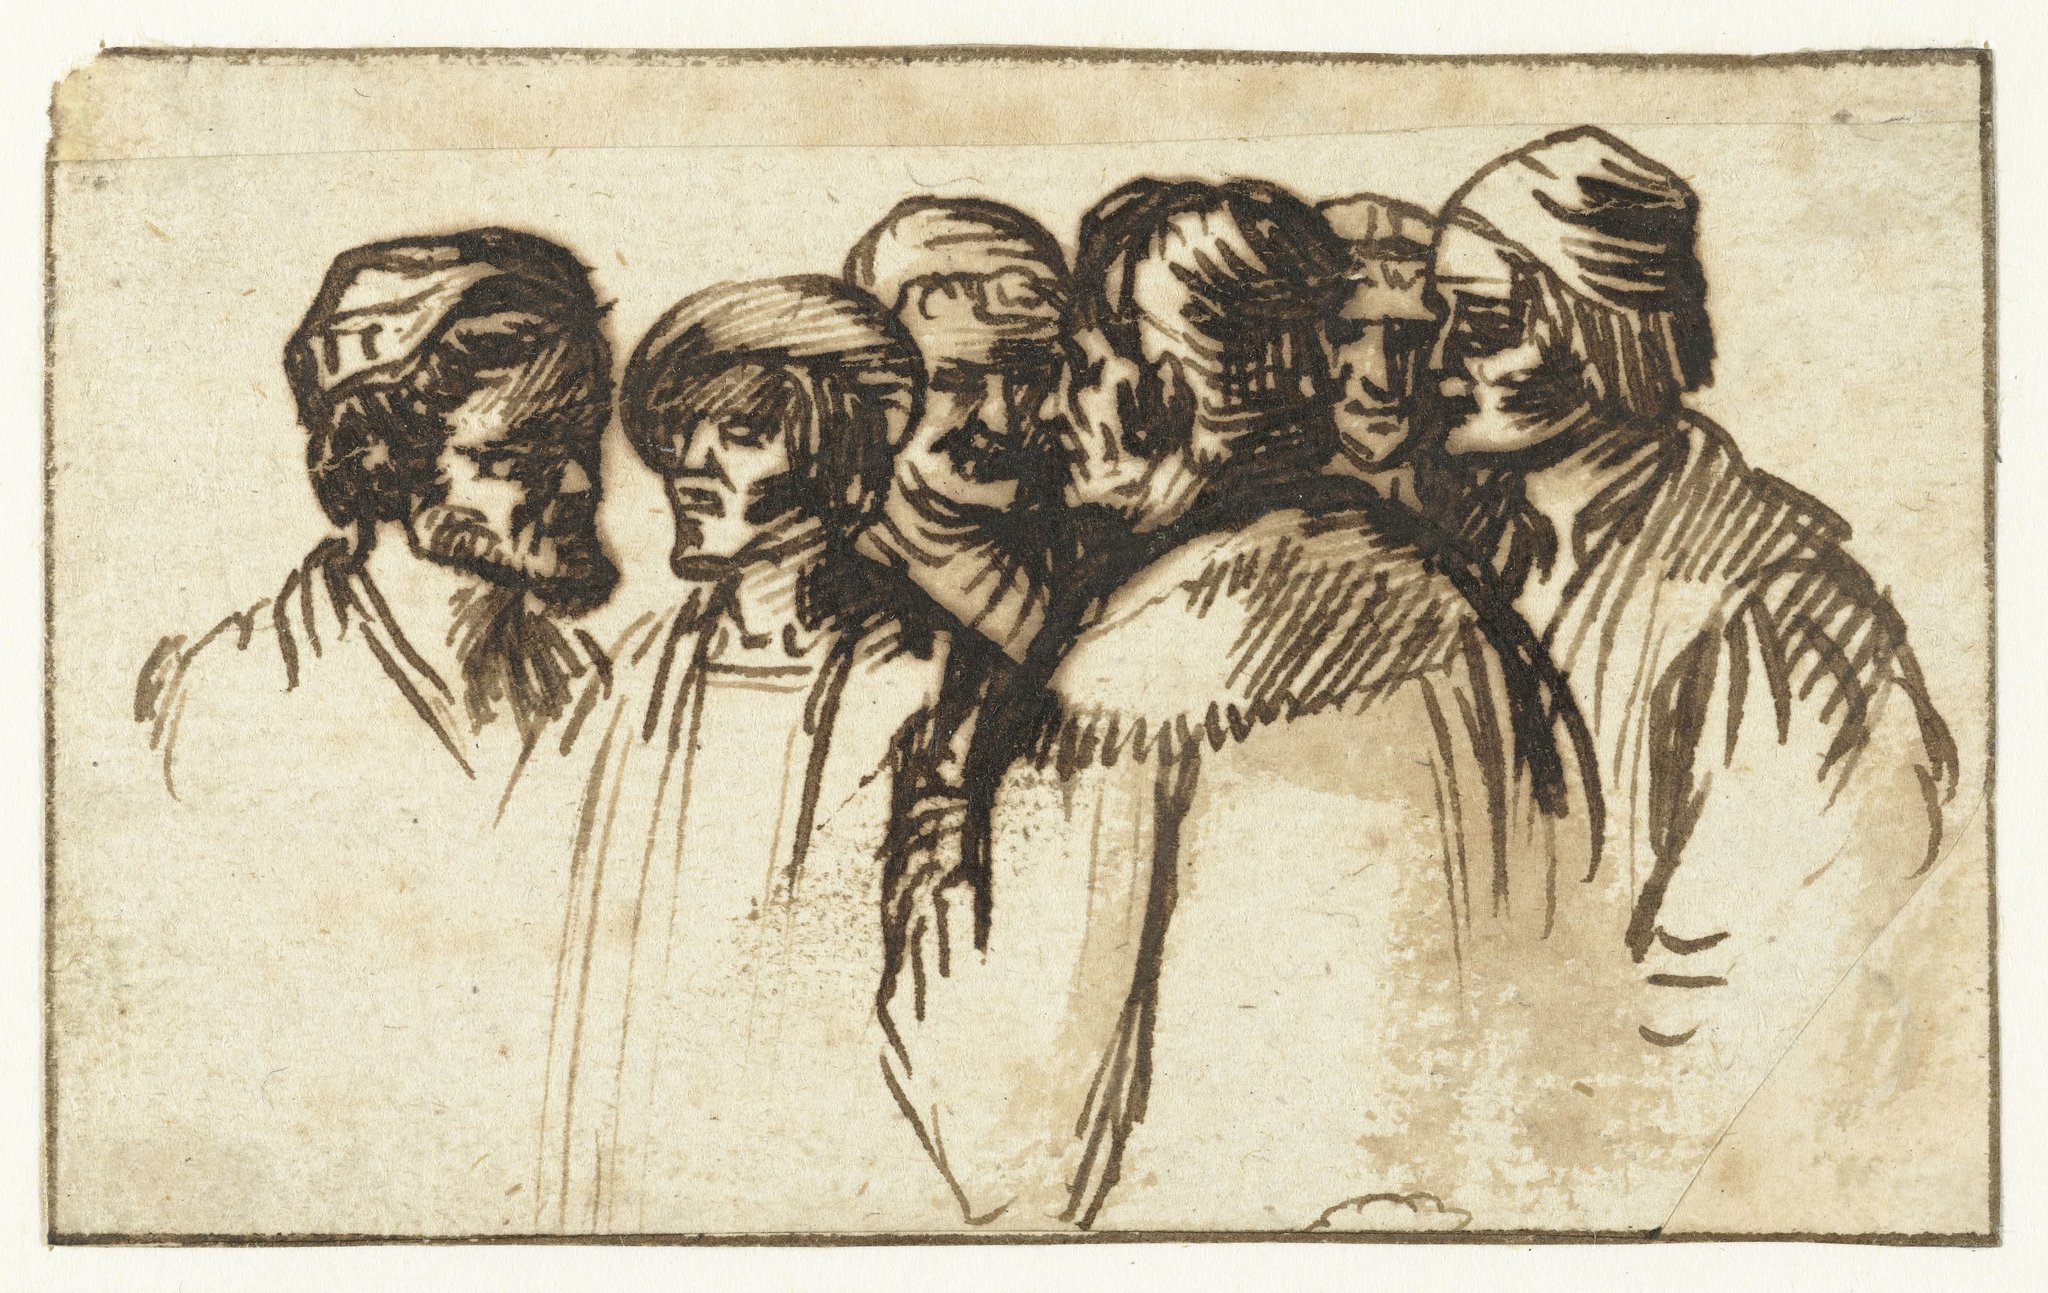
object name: drawing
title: Zes mannen met elkaar in gesprek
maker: hendrick goudt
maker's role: draughtsman, print maker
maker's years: 1581-1648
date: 1580-1650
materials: ink, paper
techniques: brush, pen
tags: physiognomy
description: Studieblad van zes mannen met elkaar in gesprek.